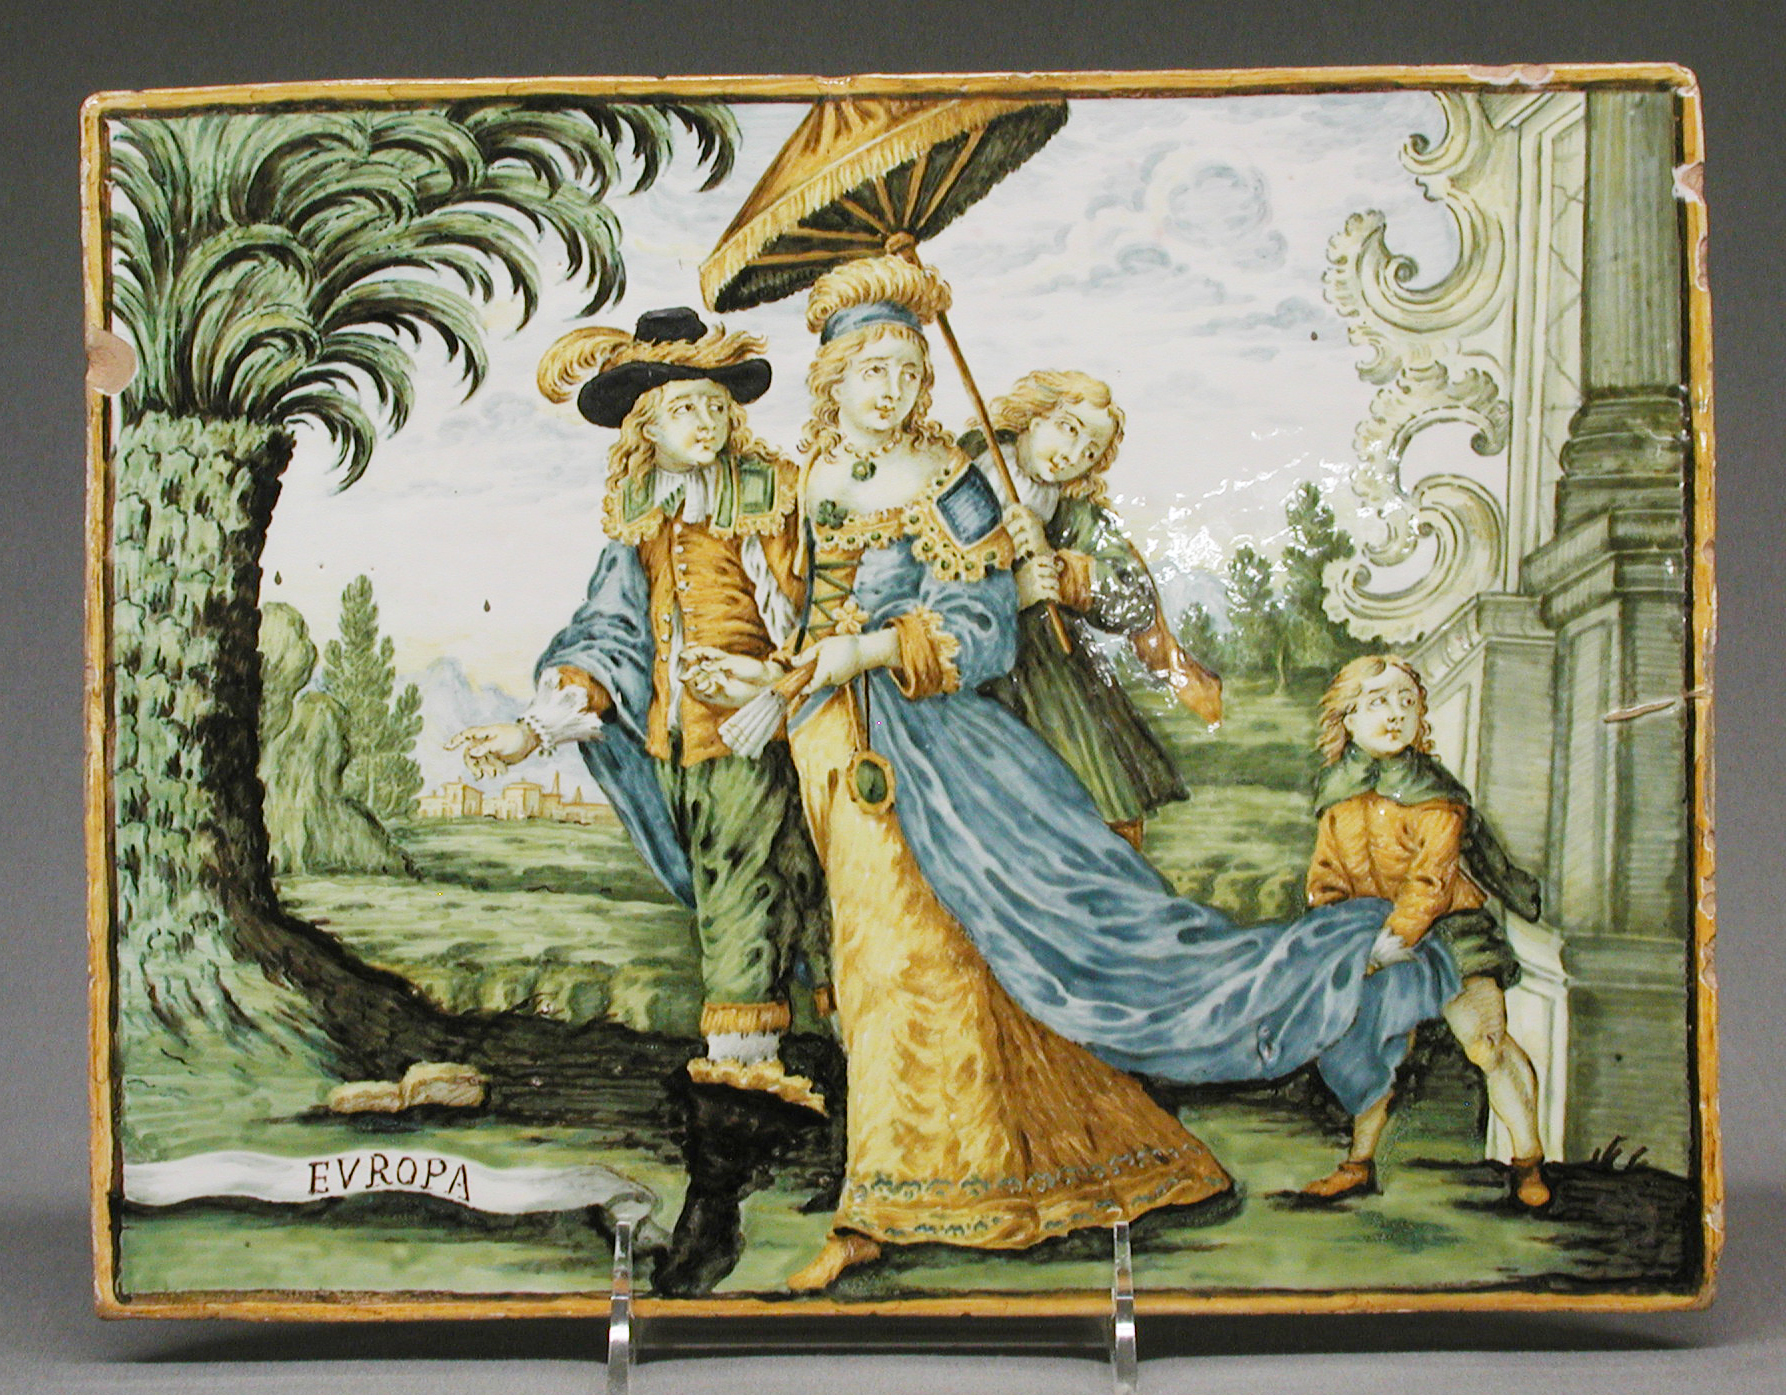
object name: tile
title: Europe (part of a set)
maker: castelli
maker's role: maker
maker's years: 1700-1900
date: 1801-1900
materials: earthenware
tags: men,women